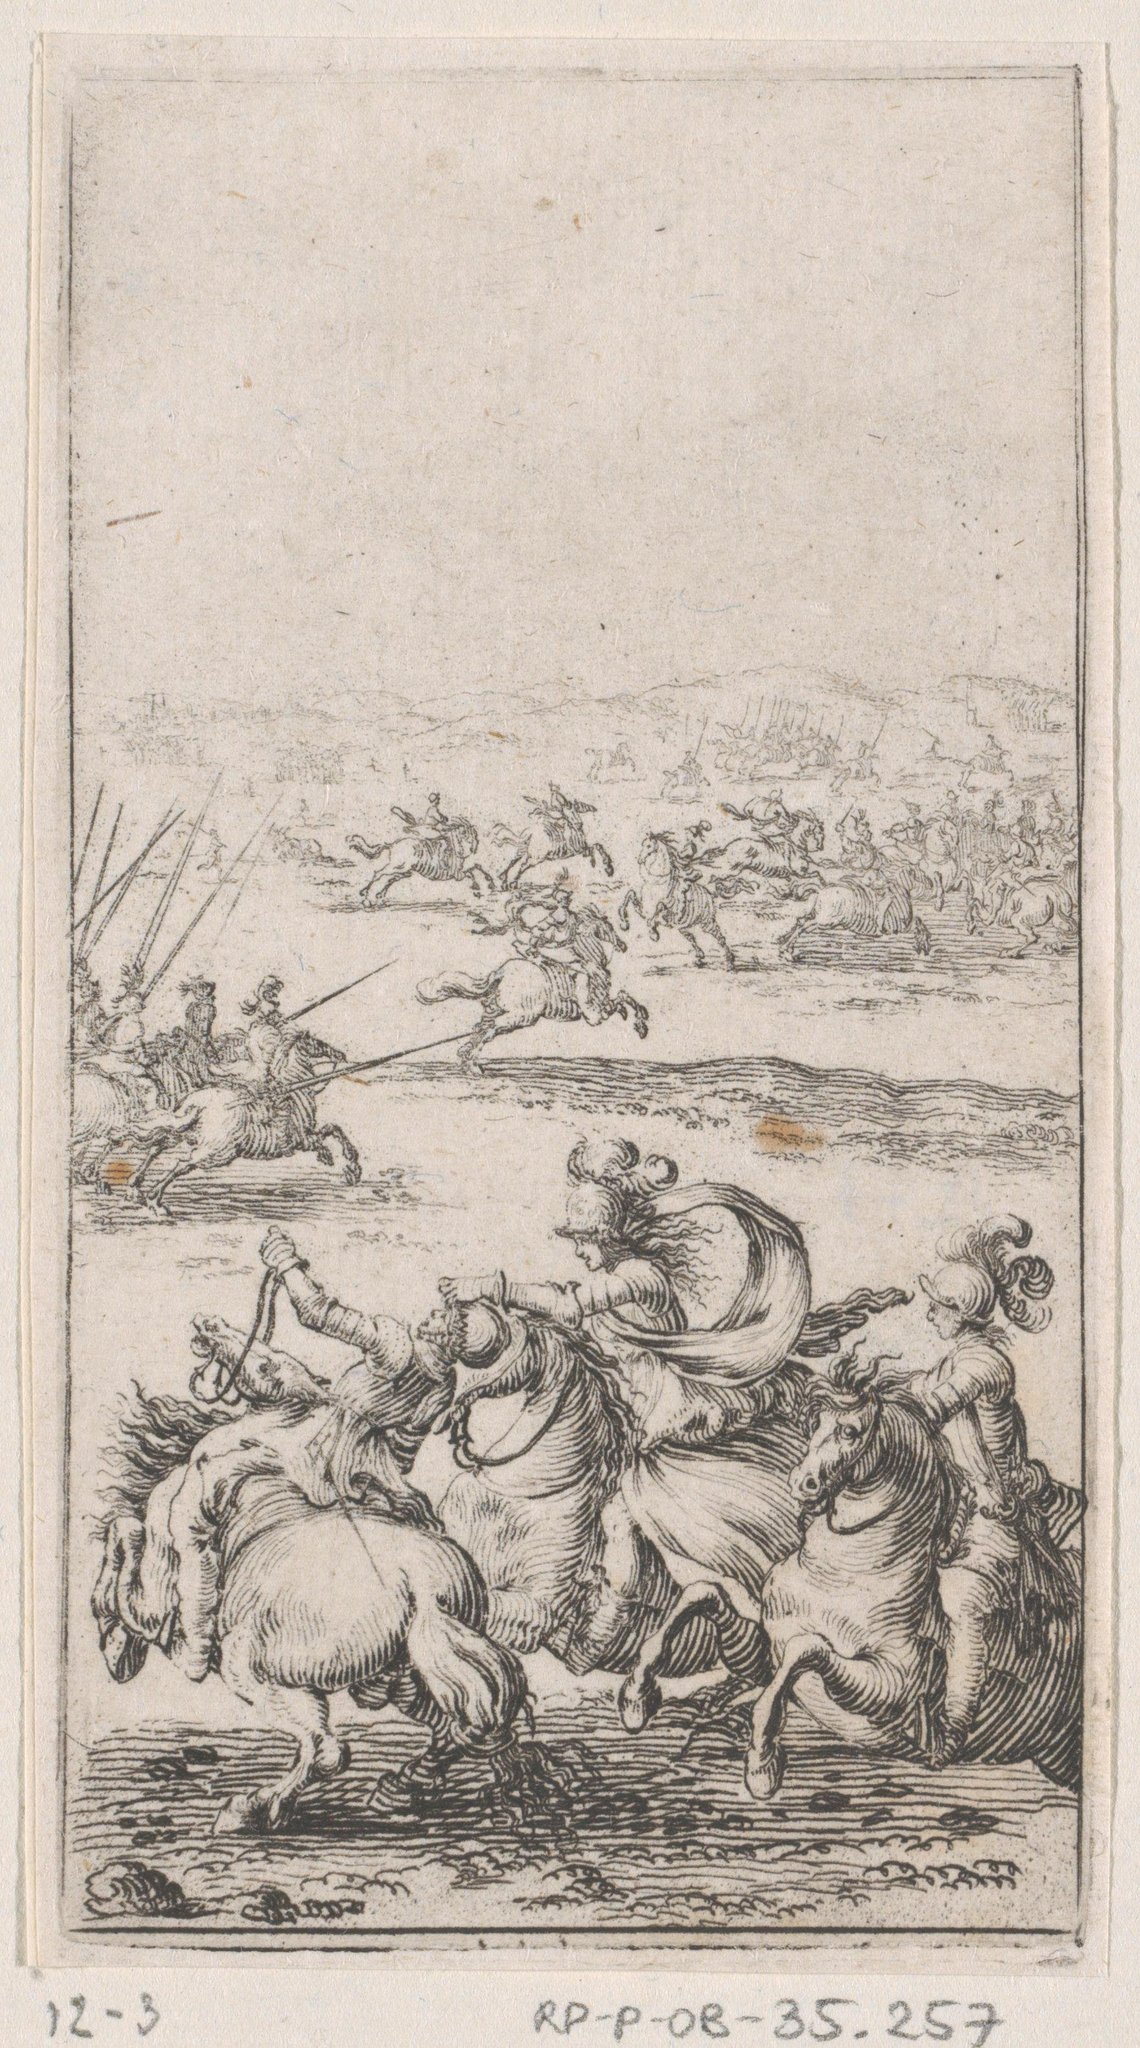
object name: print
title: Twaalf verschillende scènes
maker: Anonymous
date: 1620-1664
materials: paper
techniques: etching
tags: battle, warfare; military affairs (+ cavalry, horsemen), the soldier; the soldier's life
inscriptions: collector's mark: Lugt 240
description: Gezicht op een slagveld met soldaten te paard. Op de voorgrond drie soldaten te paard die in de aanval gaan.